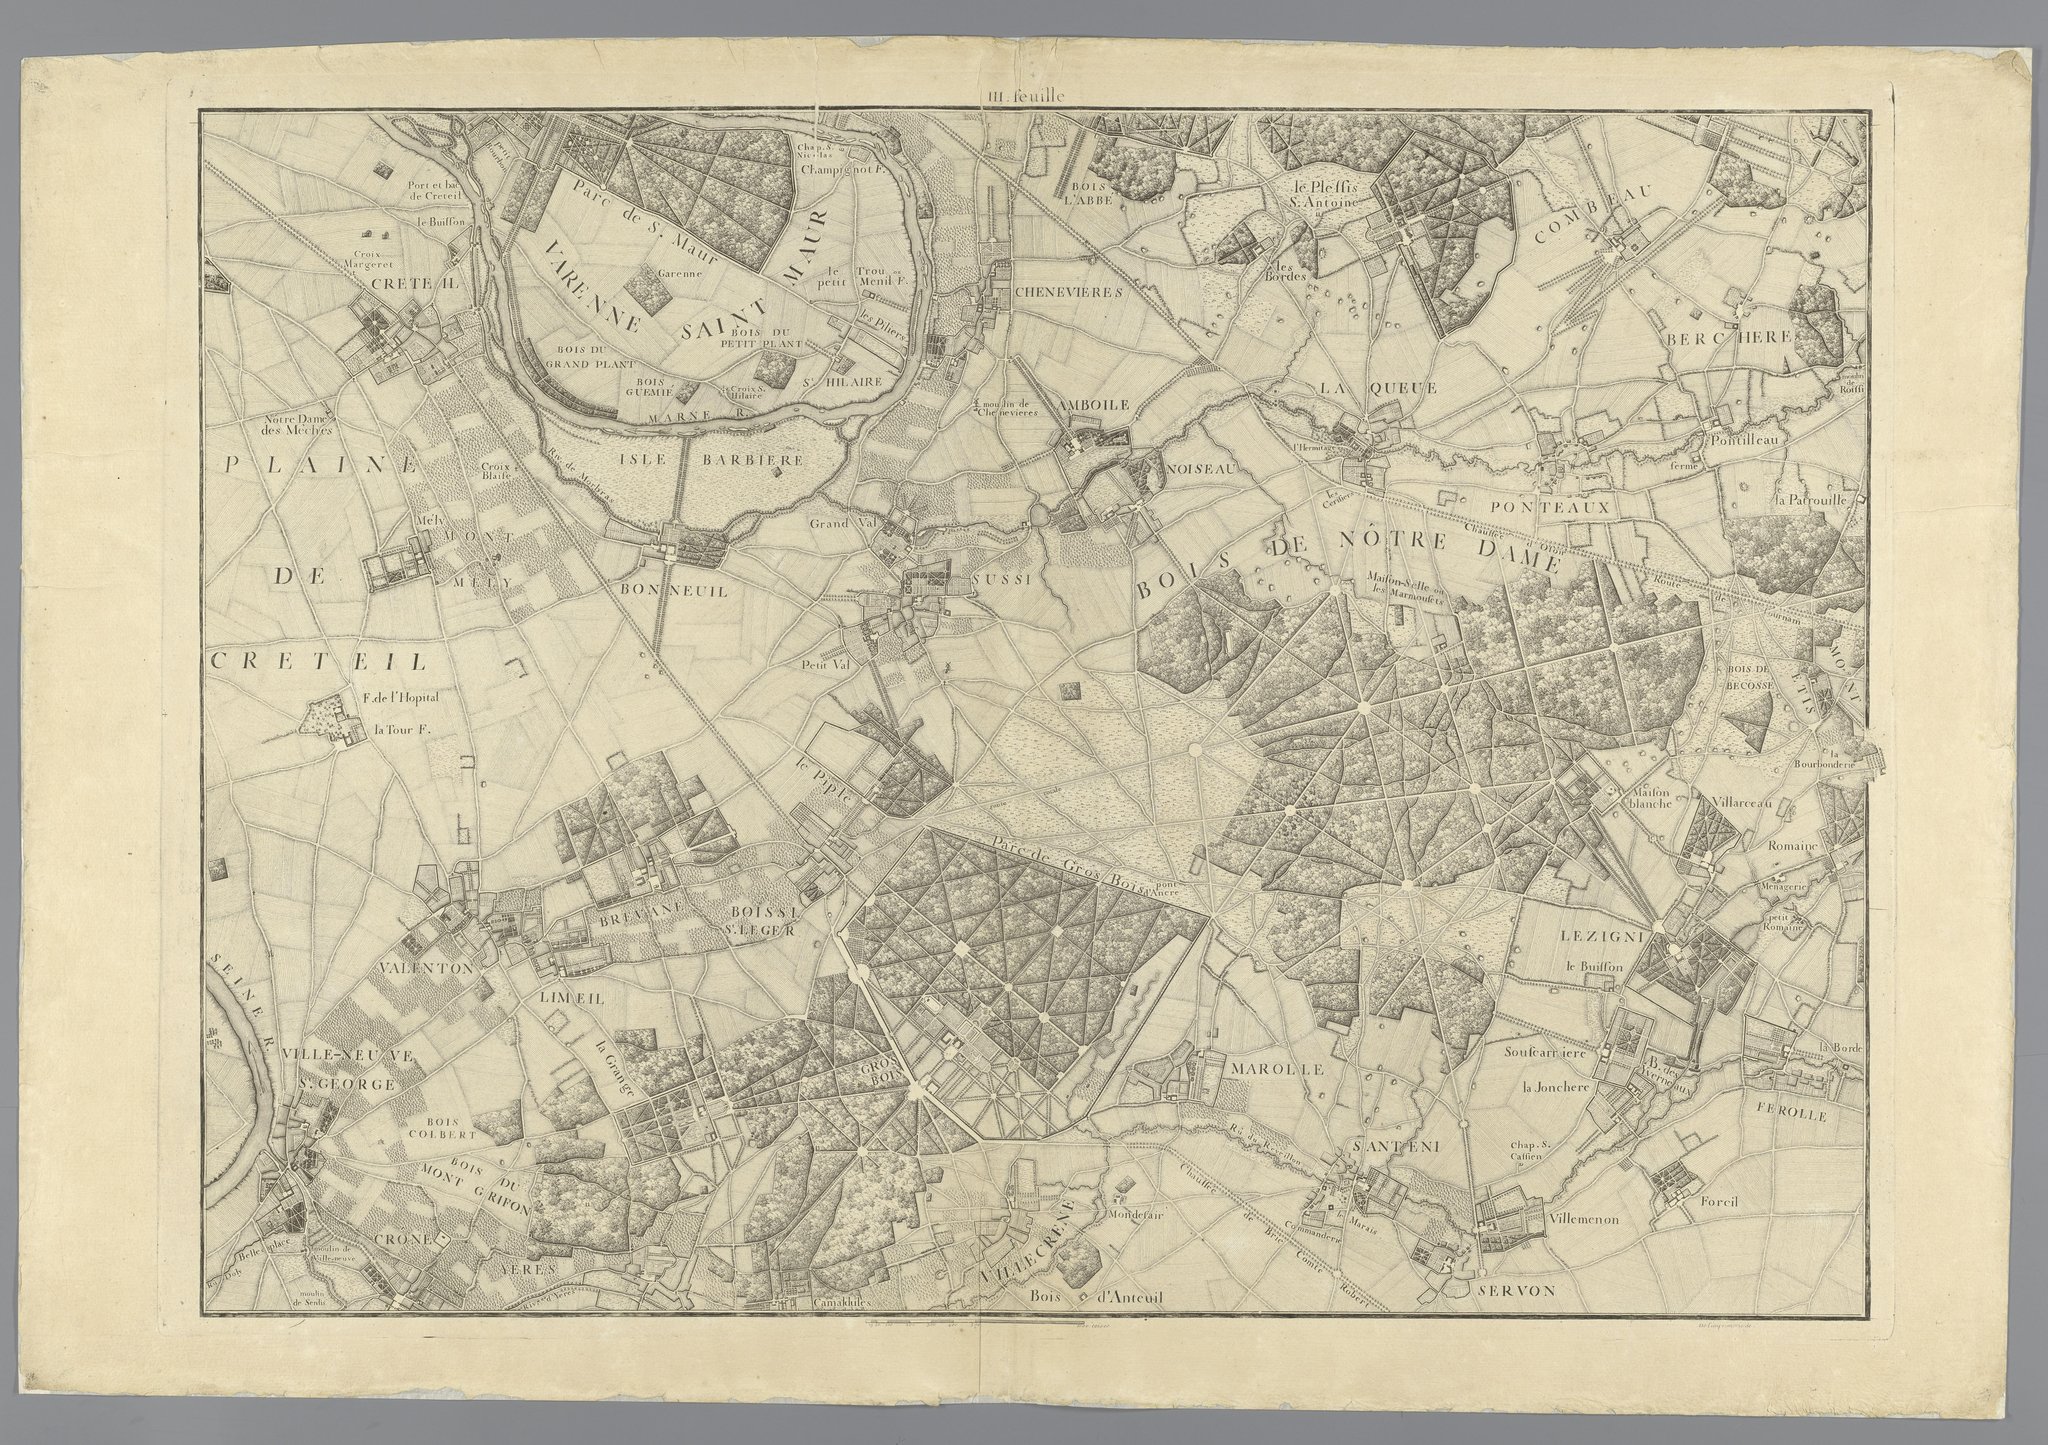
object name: print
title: Kaart van de omgeving van het bos van de Notre Dame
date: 1740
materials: paper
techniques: engraving, etching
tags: plan, map of garden, maps of cities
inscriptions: collector's mark: Lugt 2228, collector's mark: Lugt 2760